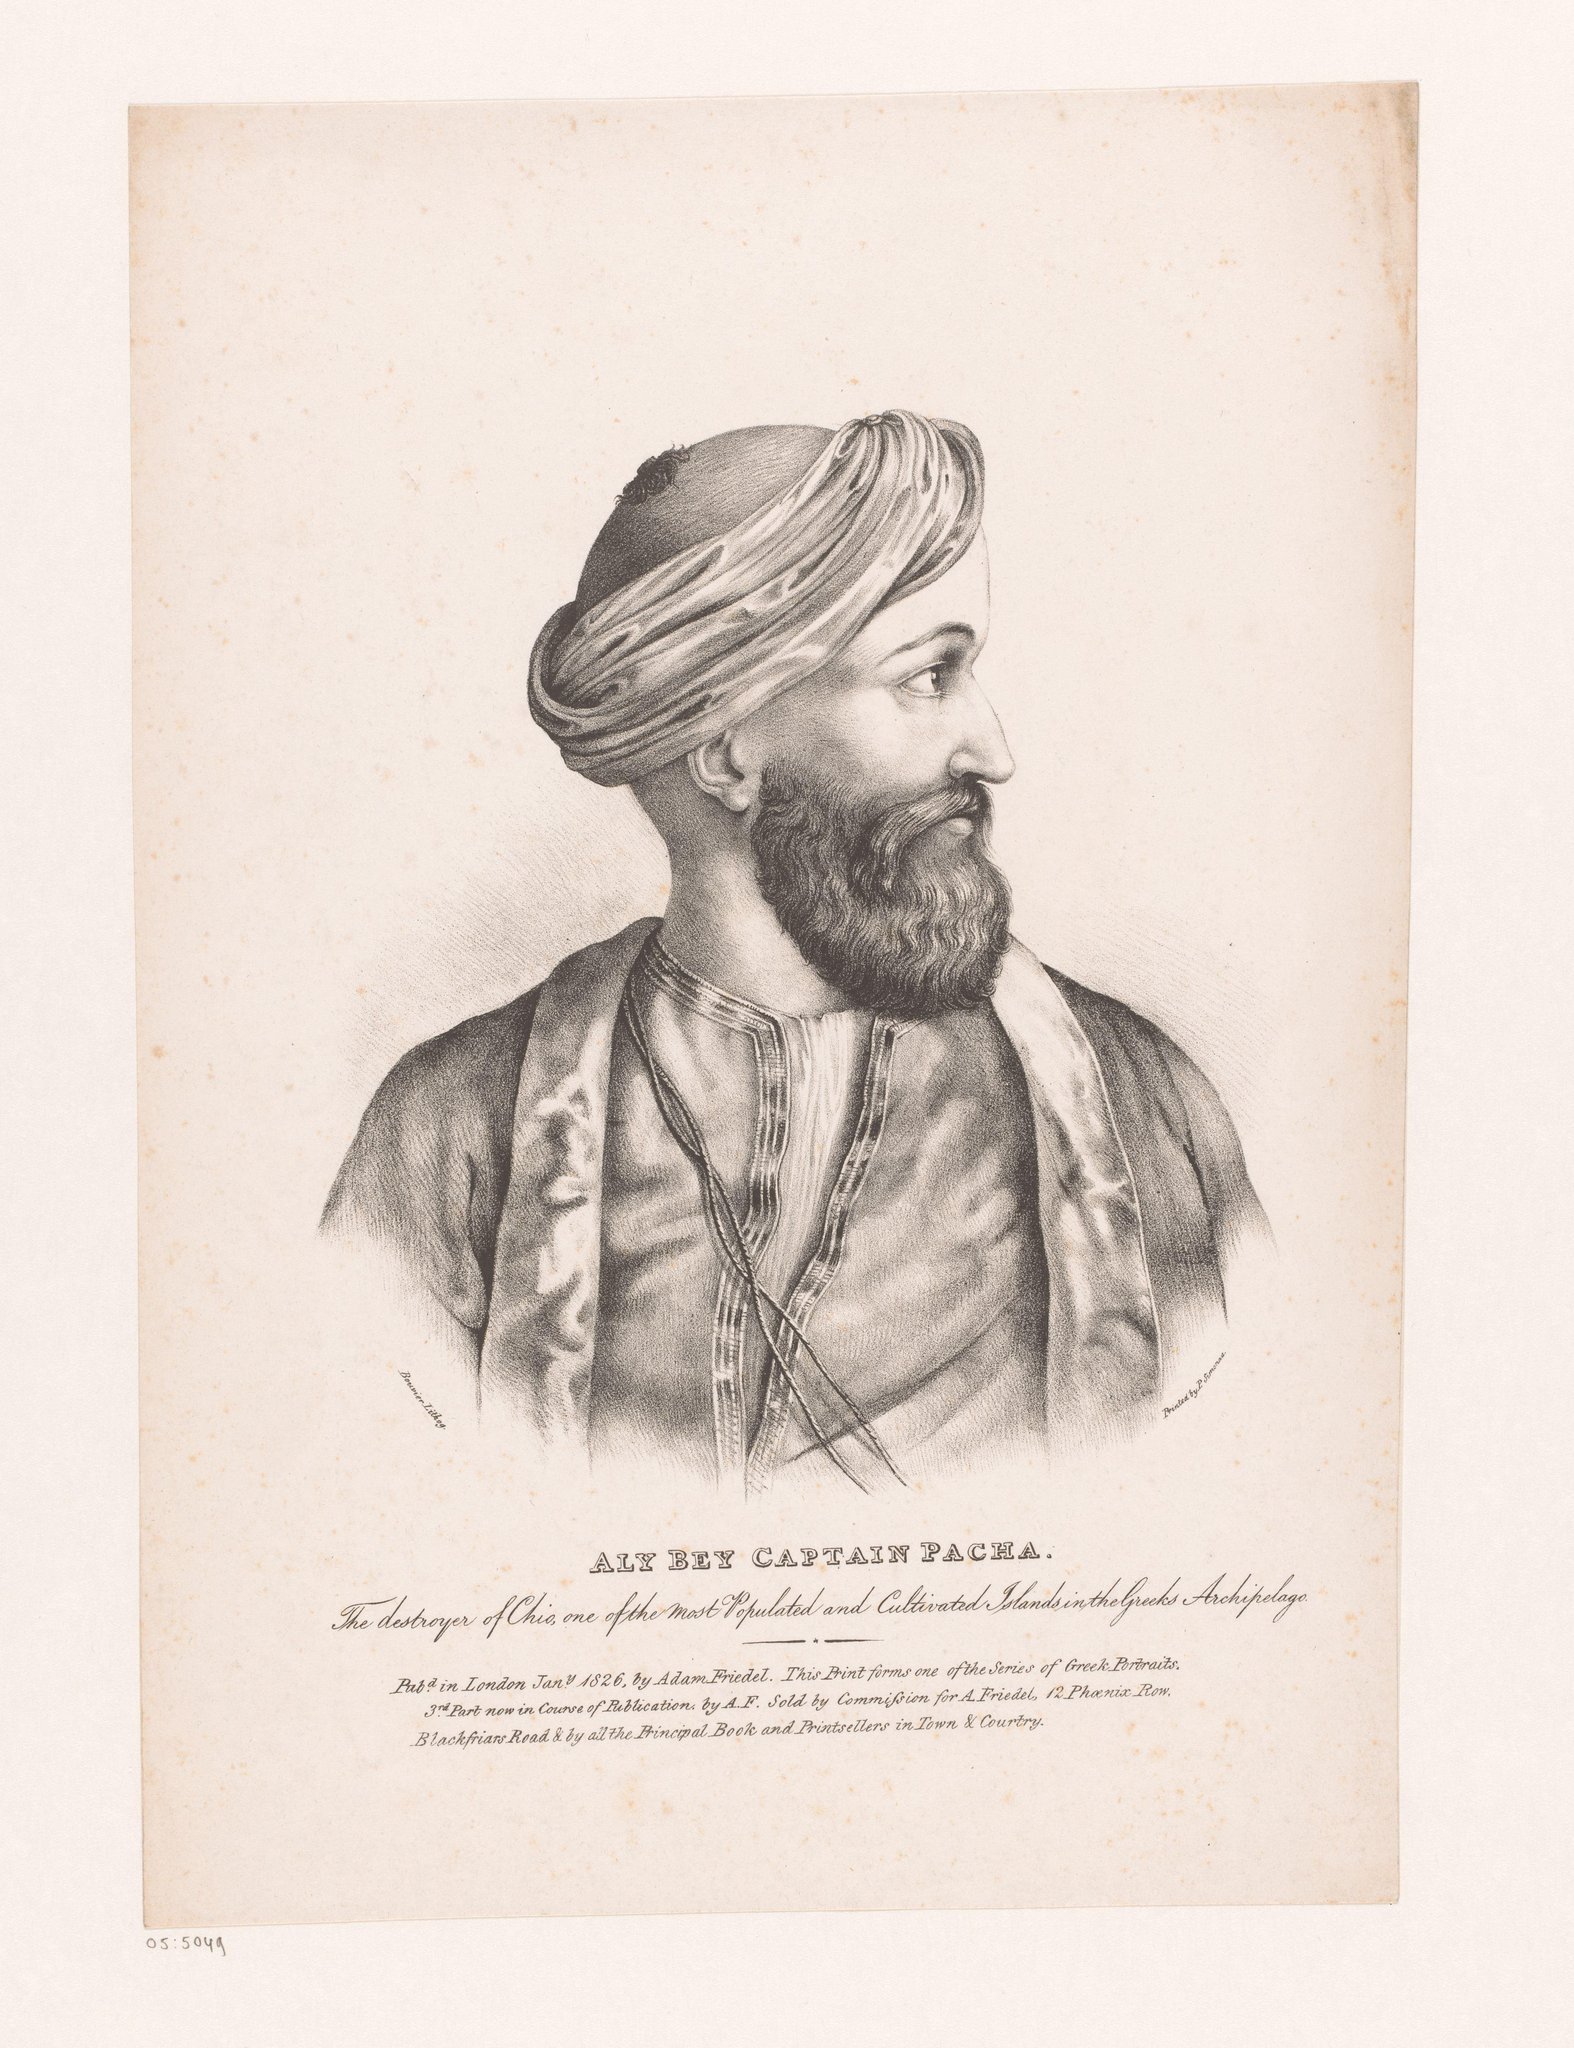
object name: print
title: Portret van Nasuhzade Ali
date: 1826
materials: paper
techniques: lithograph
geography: london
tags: historical persons, head-gear: turban, beard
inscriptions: collector's mark: Lugt 2228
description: Prent maakt onderdeel uit van een serie portretten van figuren betrokken bij de Griekse onafhankelijkheidsoorlog. Deze serie is uitgegeven door Adam Friedel in verschillende delen en edities.